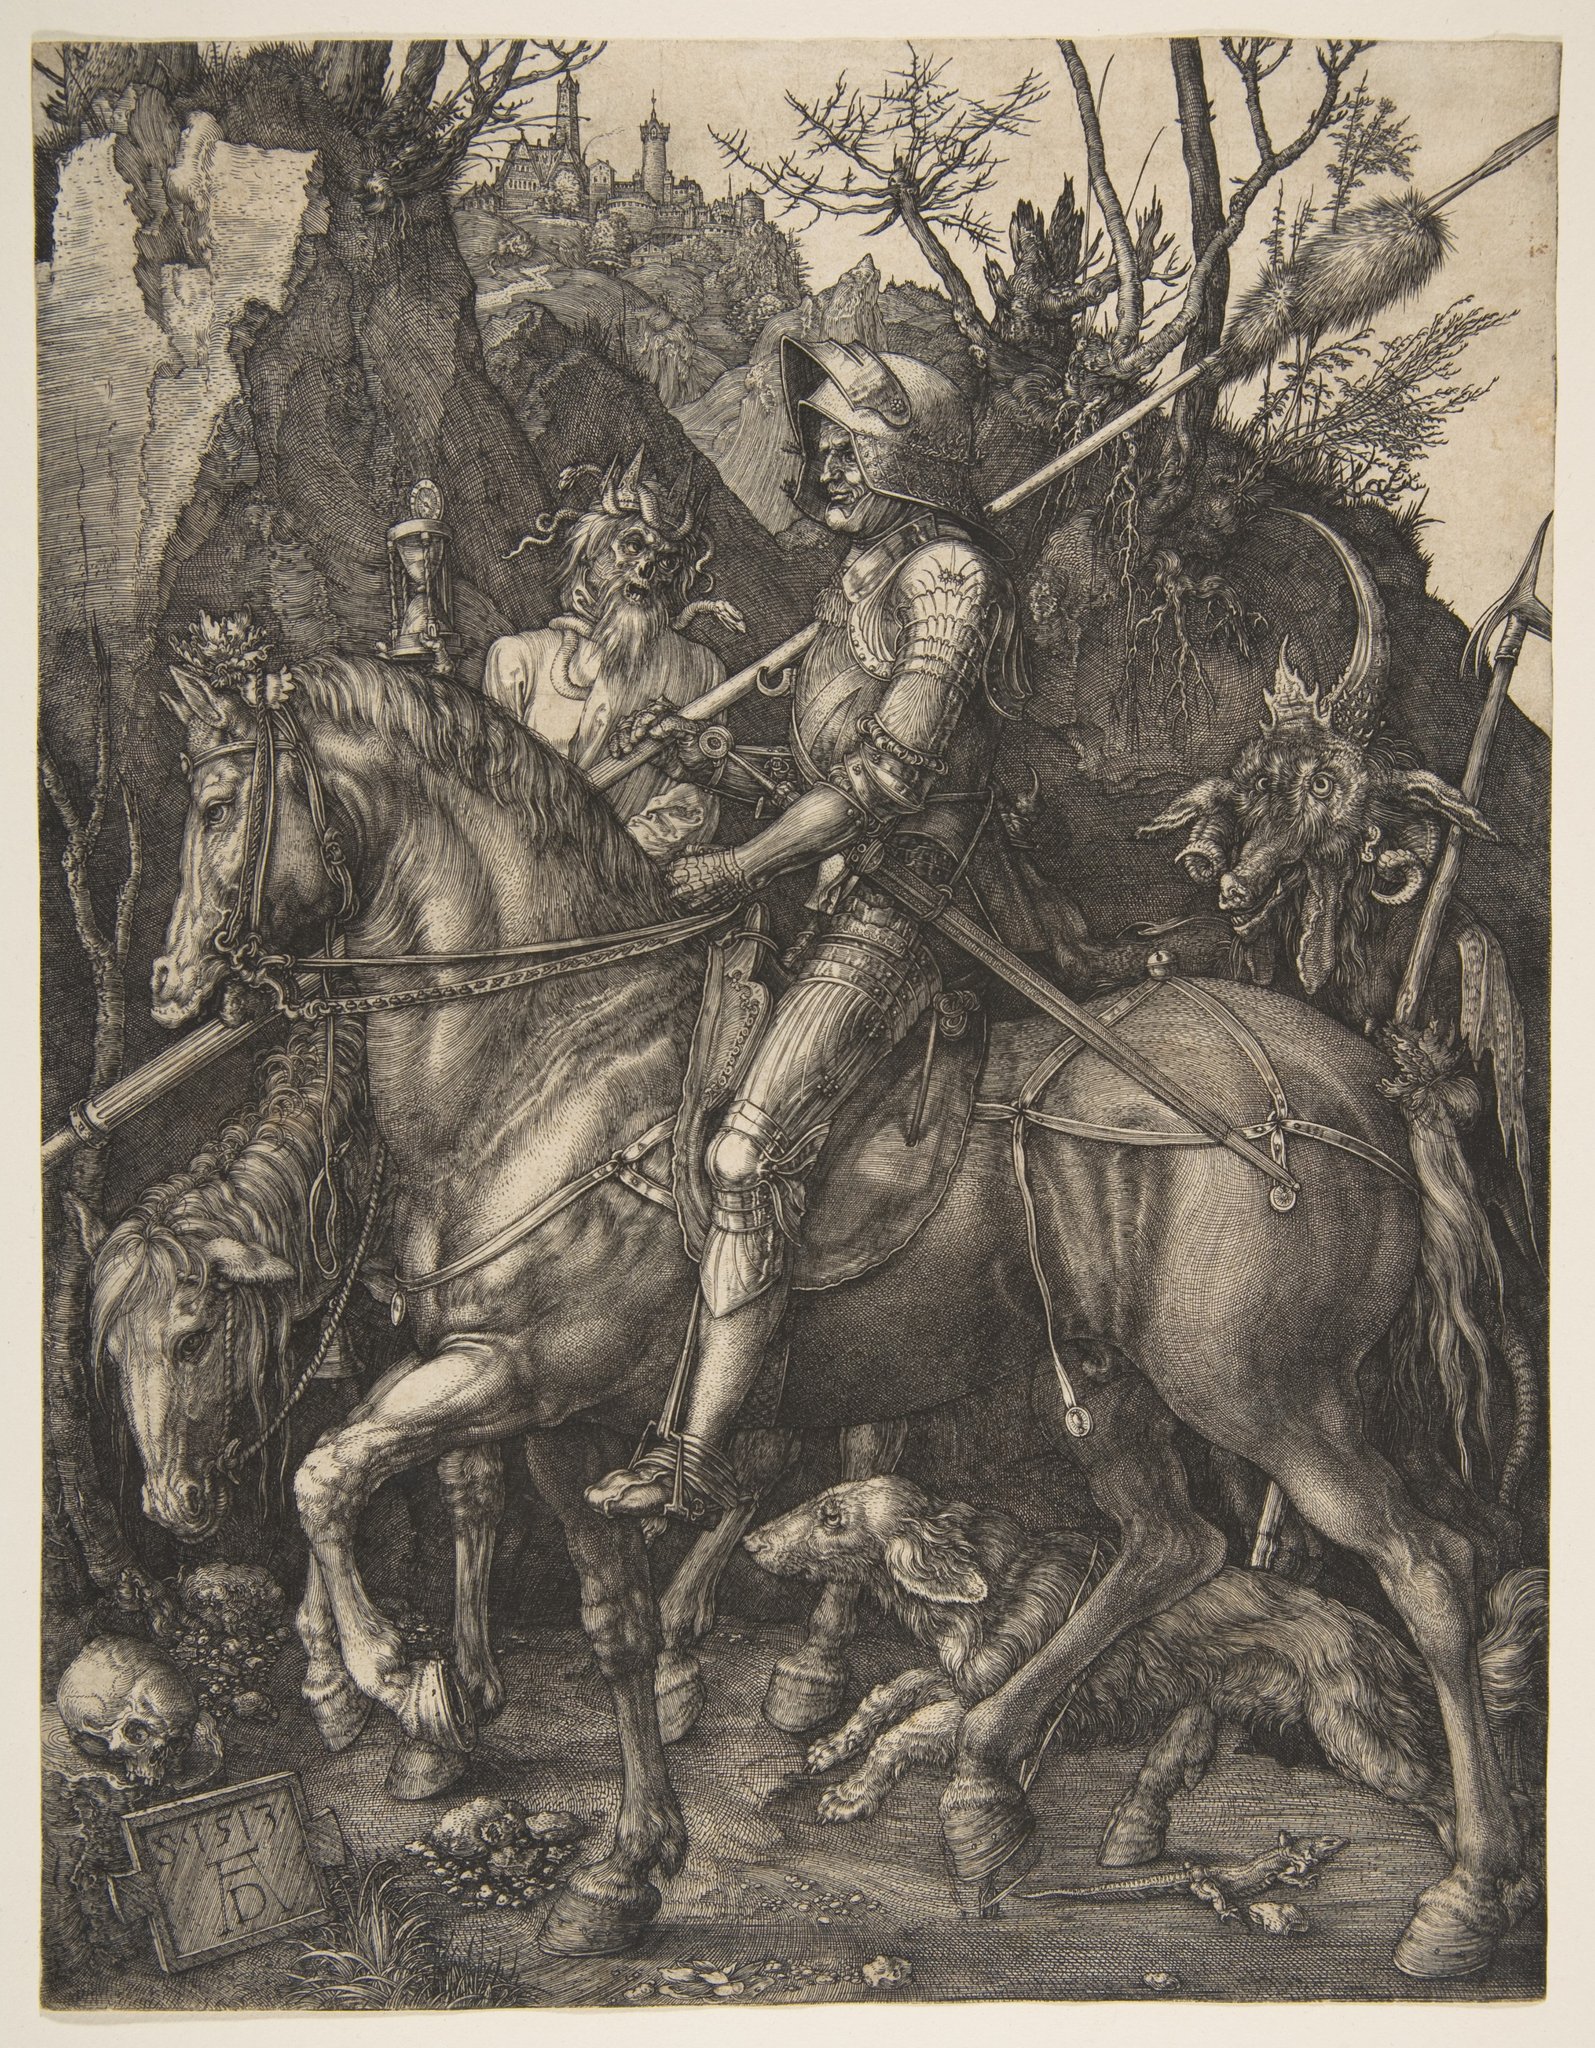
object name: print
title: Knight, Death, and the Devil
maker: albrecht dürer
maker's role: artist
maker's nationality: german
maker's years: 1471-1528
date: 1513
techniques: engraving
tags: dogs,horses,devil,knights